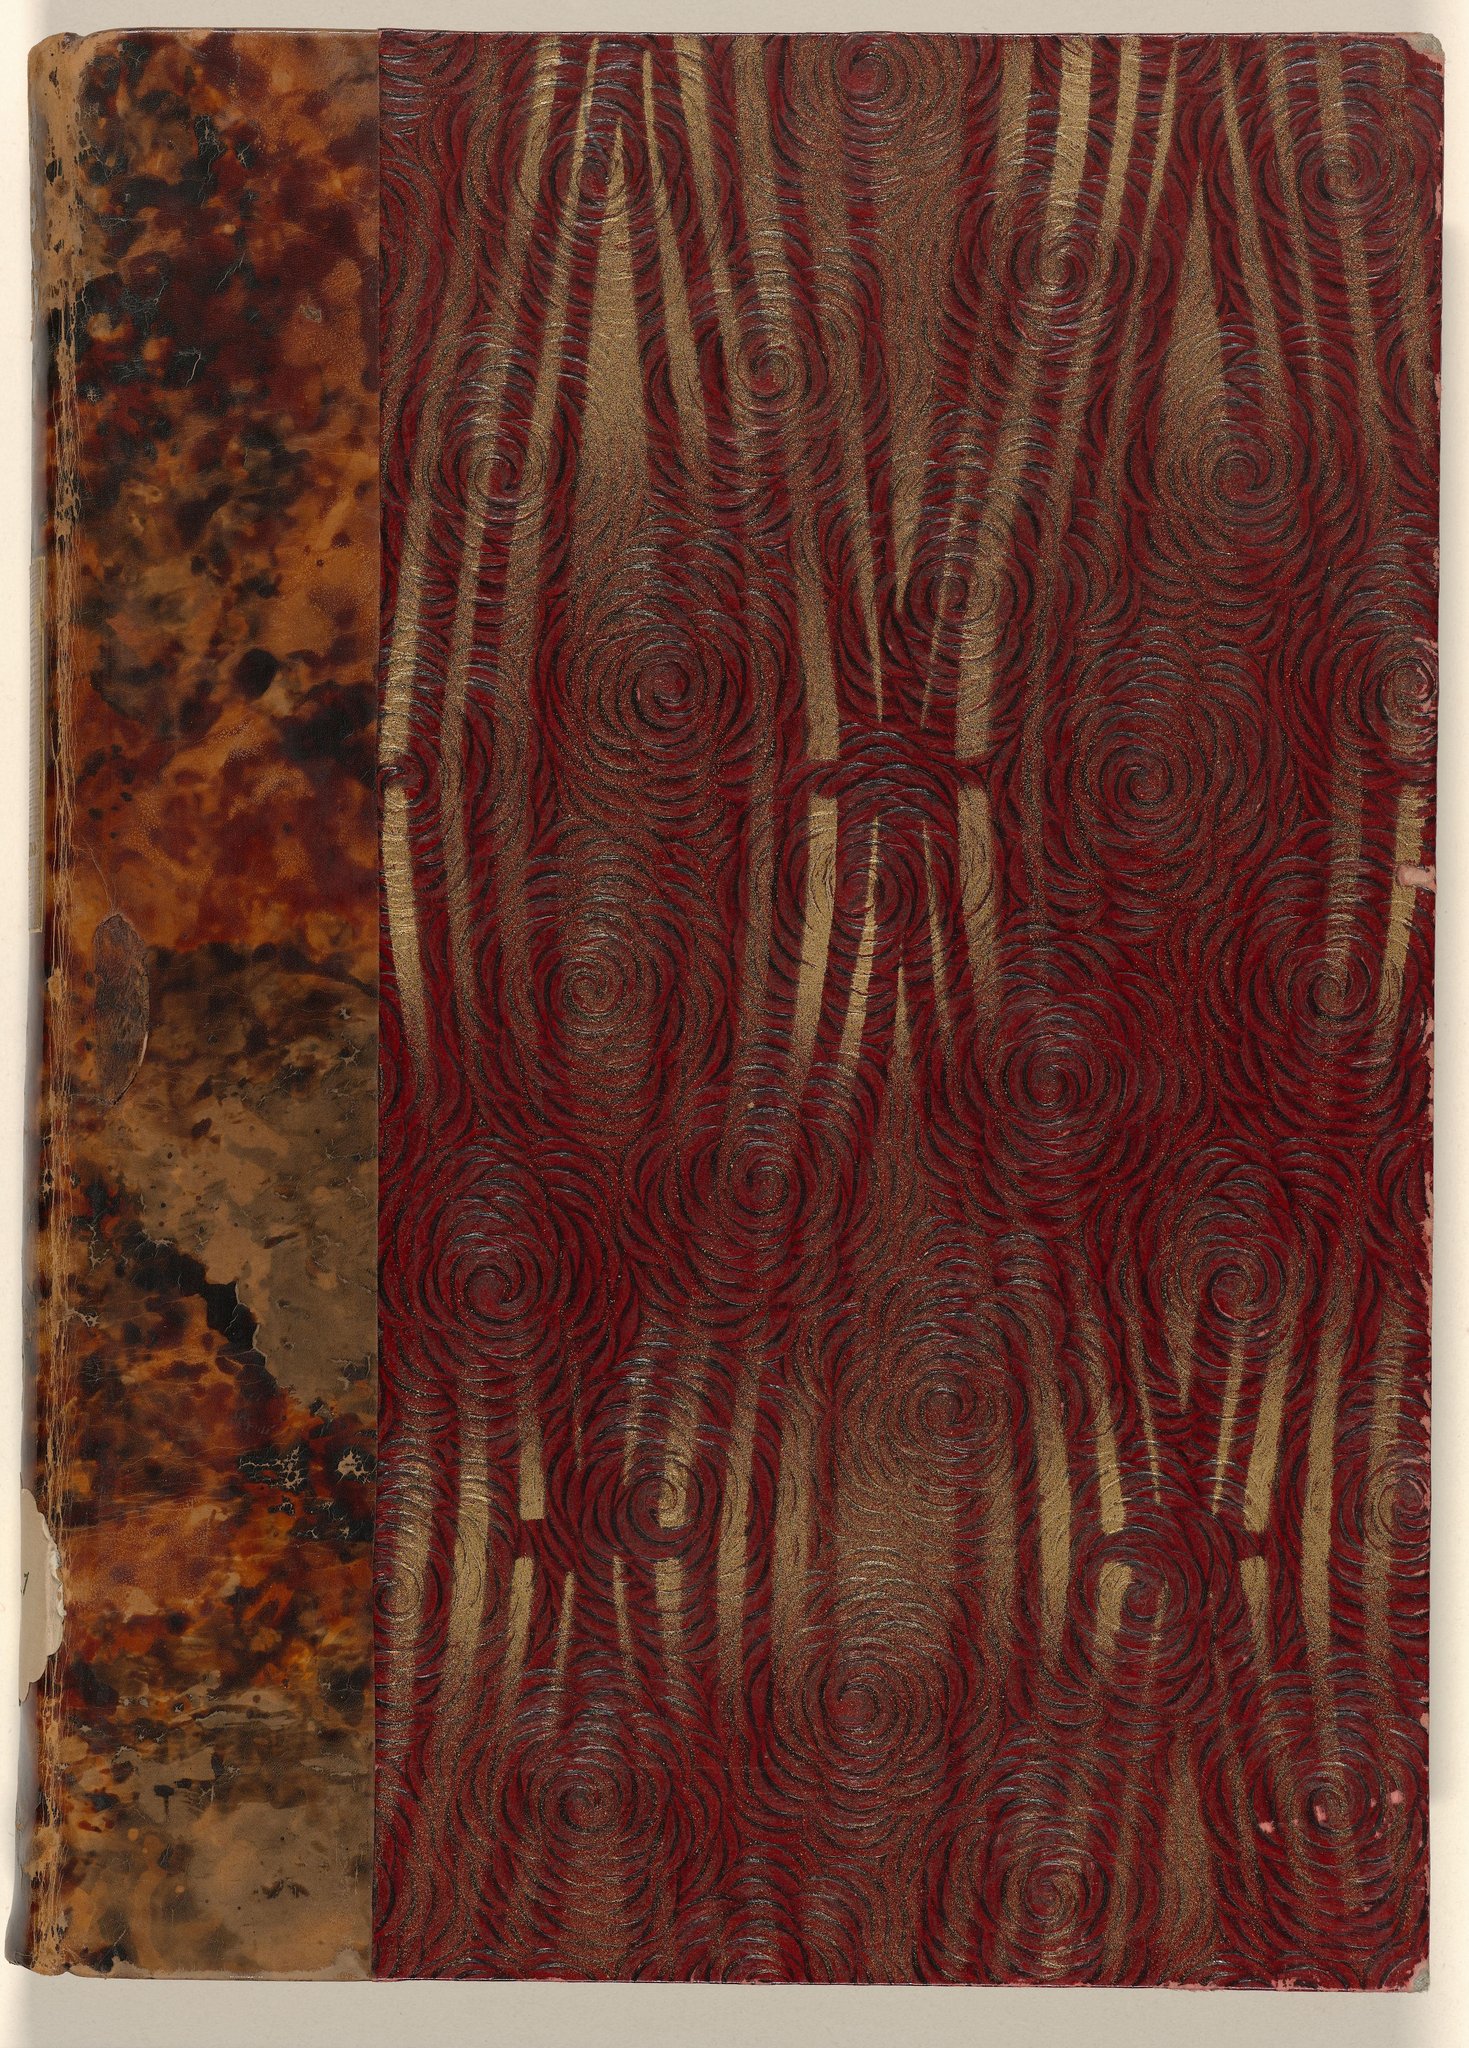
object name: book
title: Boek met fabels van La Fontaine geïllustreerd met Japanse prenten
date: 1894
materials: cardboard, paper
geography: japan